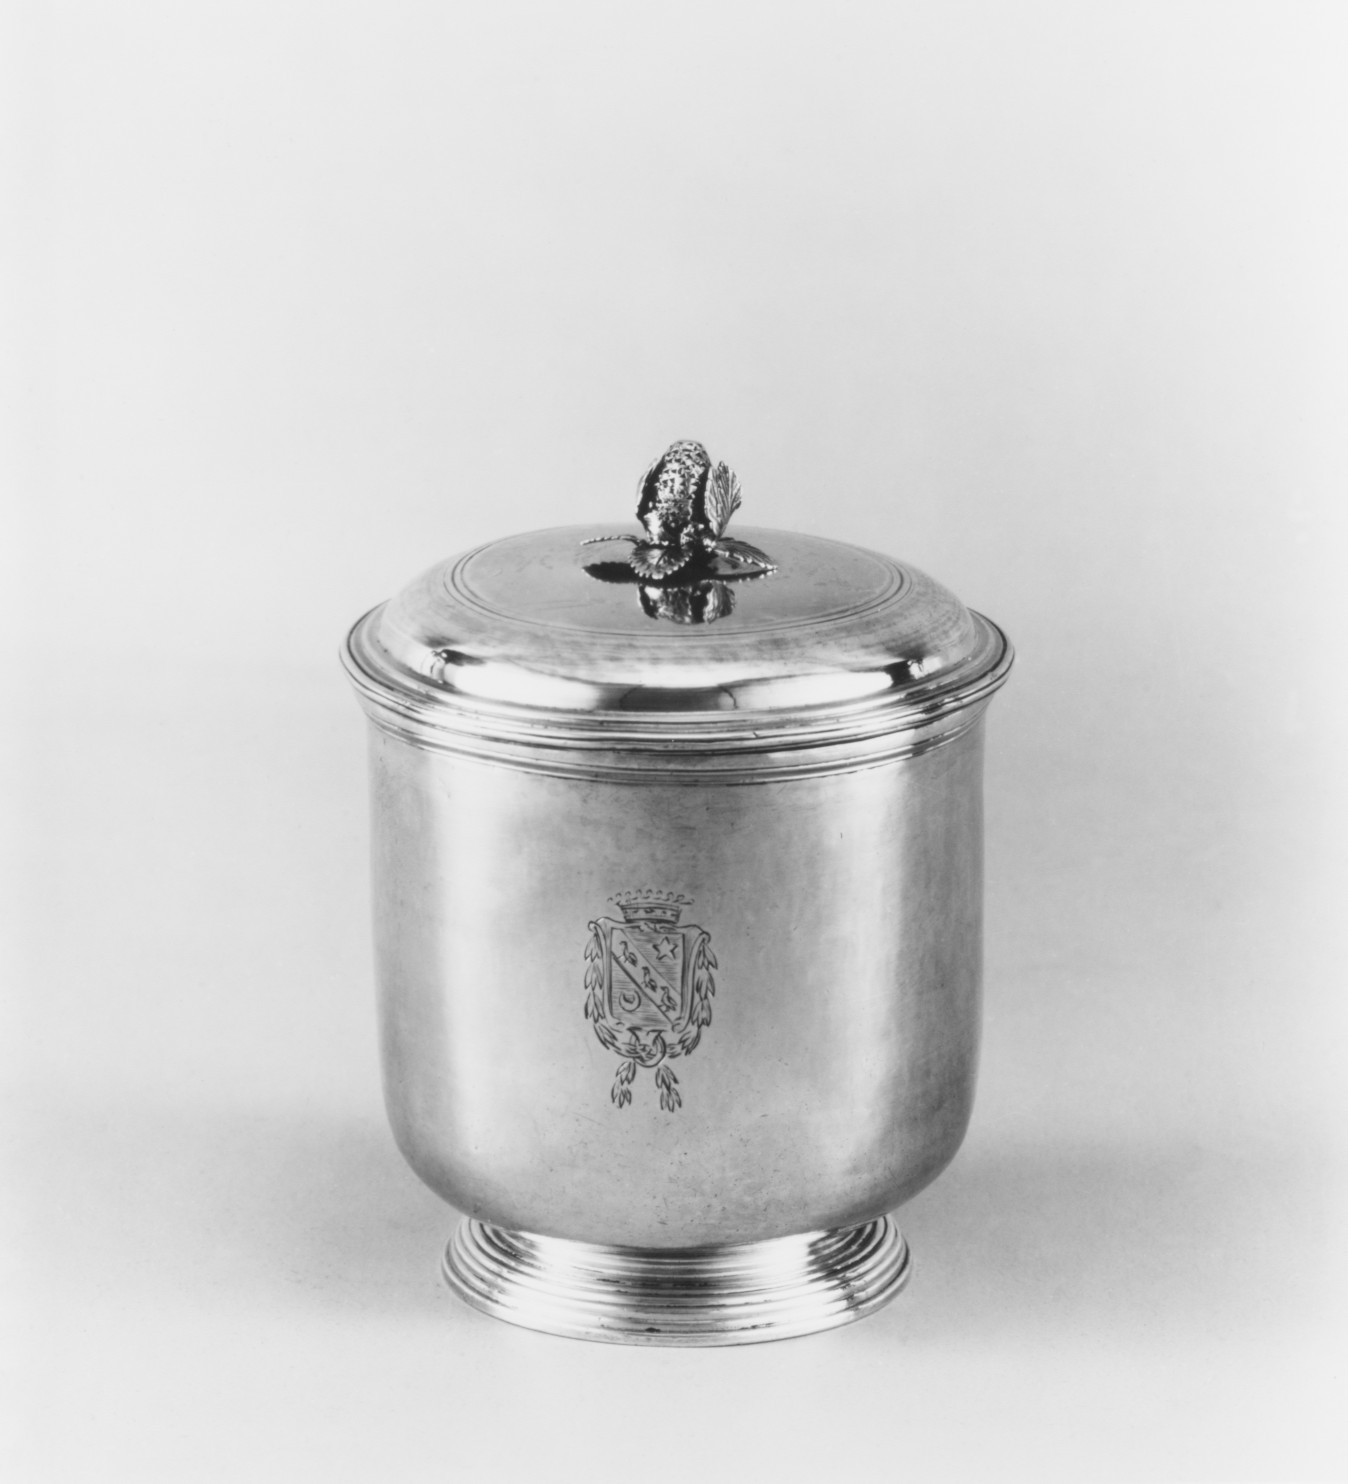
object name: sugar bowl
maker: sébastien igonet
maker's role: maker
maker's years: 1695-1796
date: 1753-1754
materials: silver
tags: coat of arms